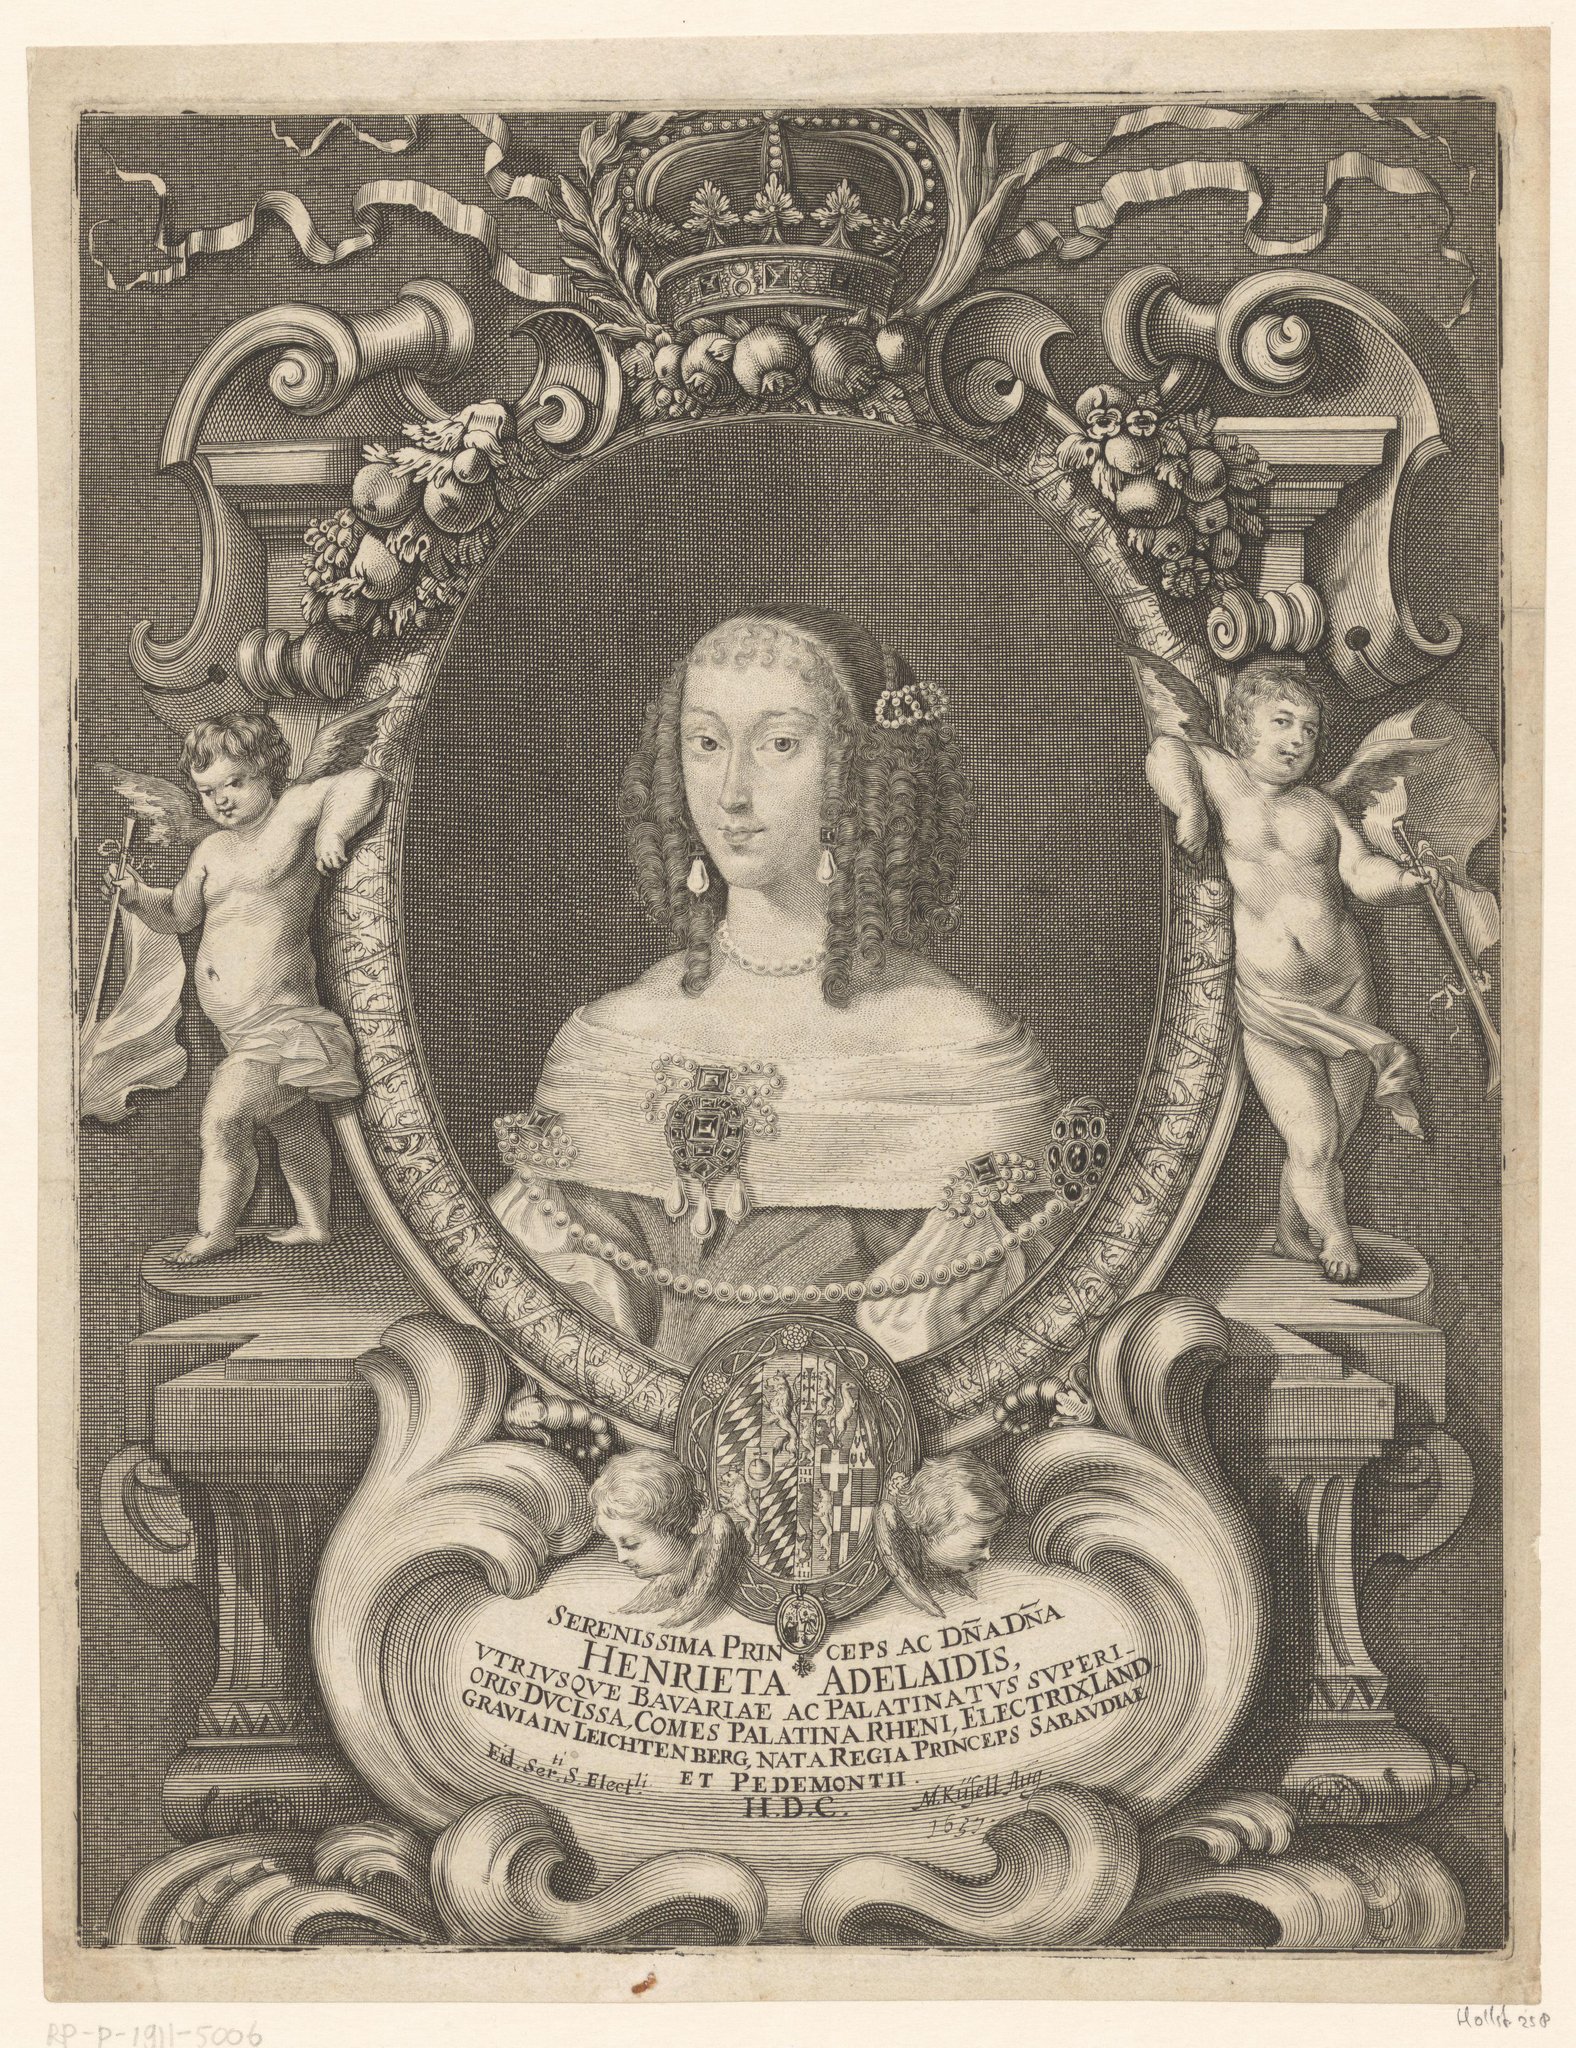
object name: print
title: Portret van Henriëtte Adelheid van Savoye, prinses van Beieren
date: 1657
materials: paper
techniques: engraving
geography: augsburg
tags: henriëtte adelheid van savoye, historical persons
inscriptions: collector's mark: Lugt 2228